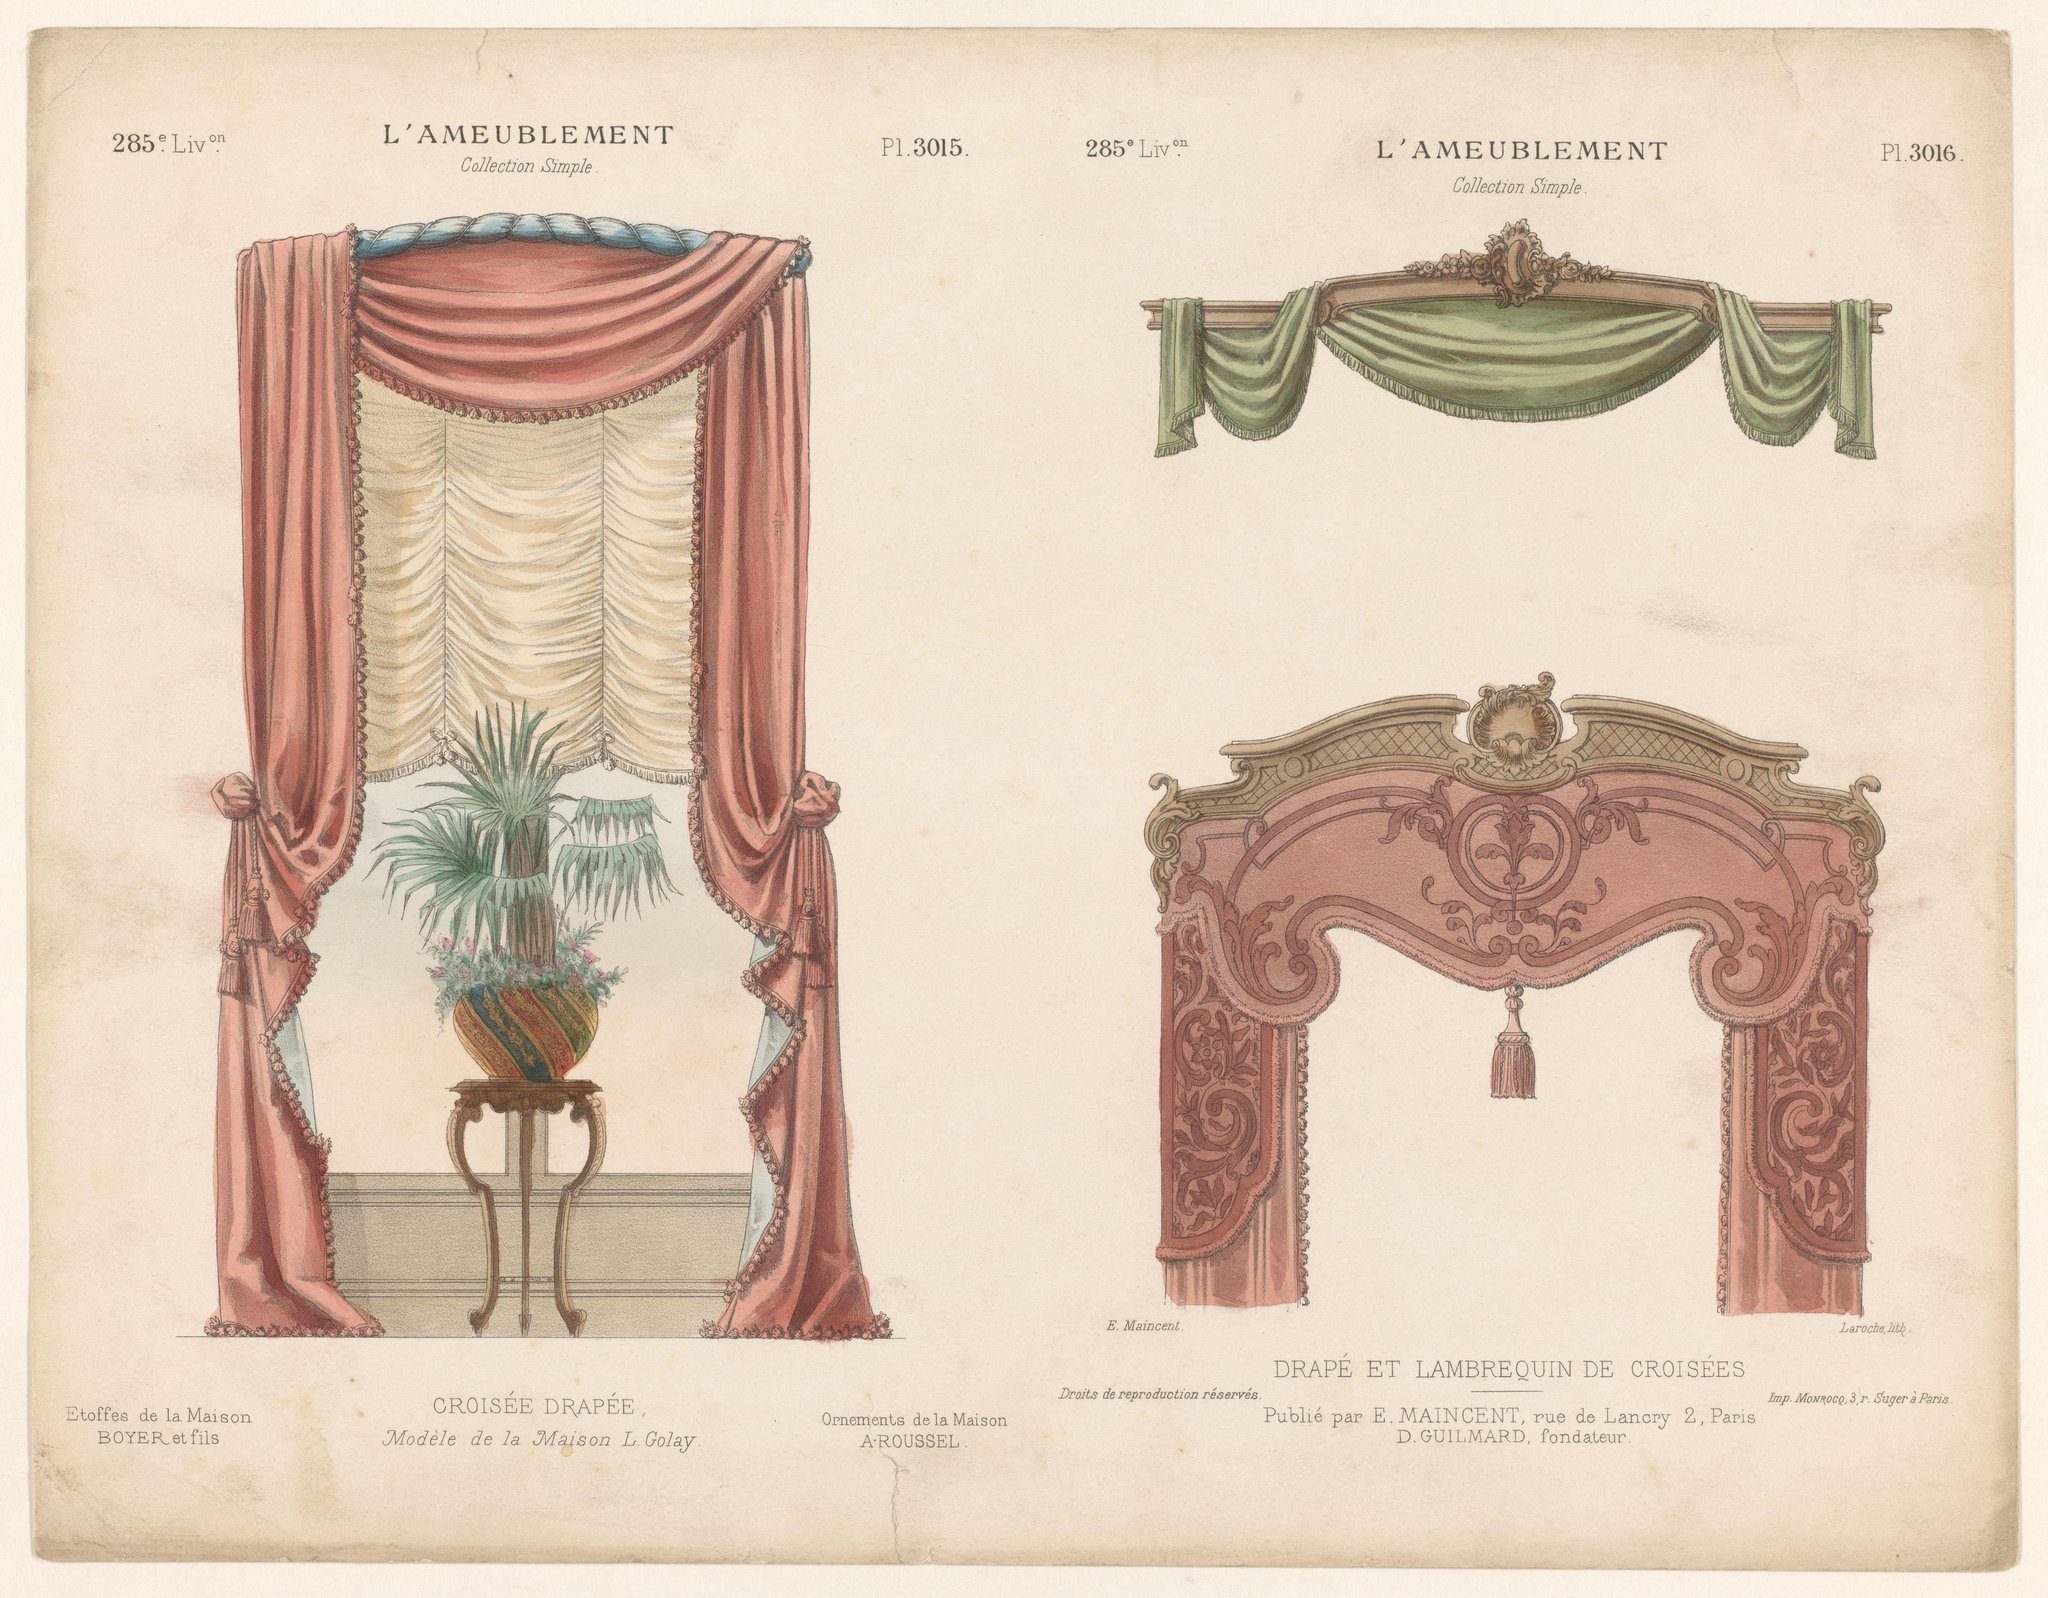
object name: print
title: Venster met gordijnen en lambrekijns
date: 1885-1895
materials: paper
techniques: hand coloring, lithograph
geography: paris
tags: window, hangings and drapery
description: Een venster met gedrapeerde gordijnen en twee lambrekijns. Prent uit 285e Livraison.